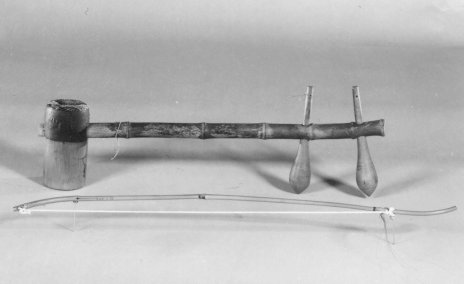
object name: hu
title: Hu Hu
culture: chinese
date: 1801-1900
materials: bamboo, hair, skin, wood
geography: china